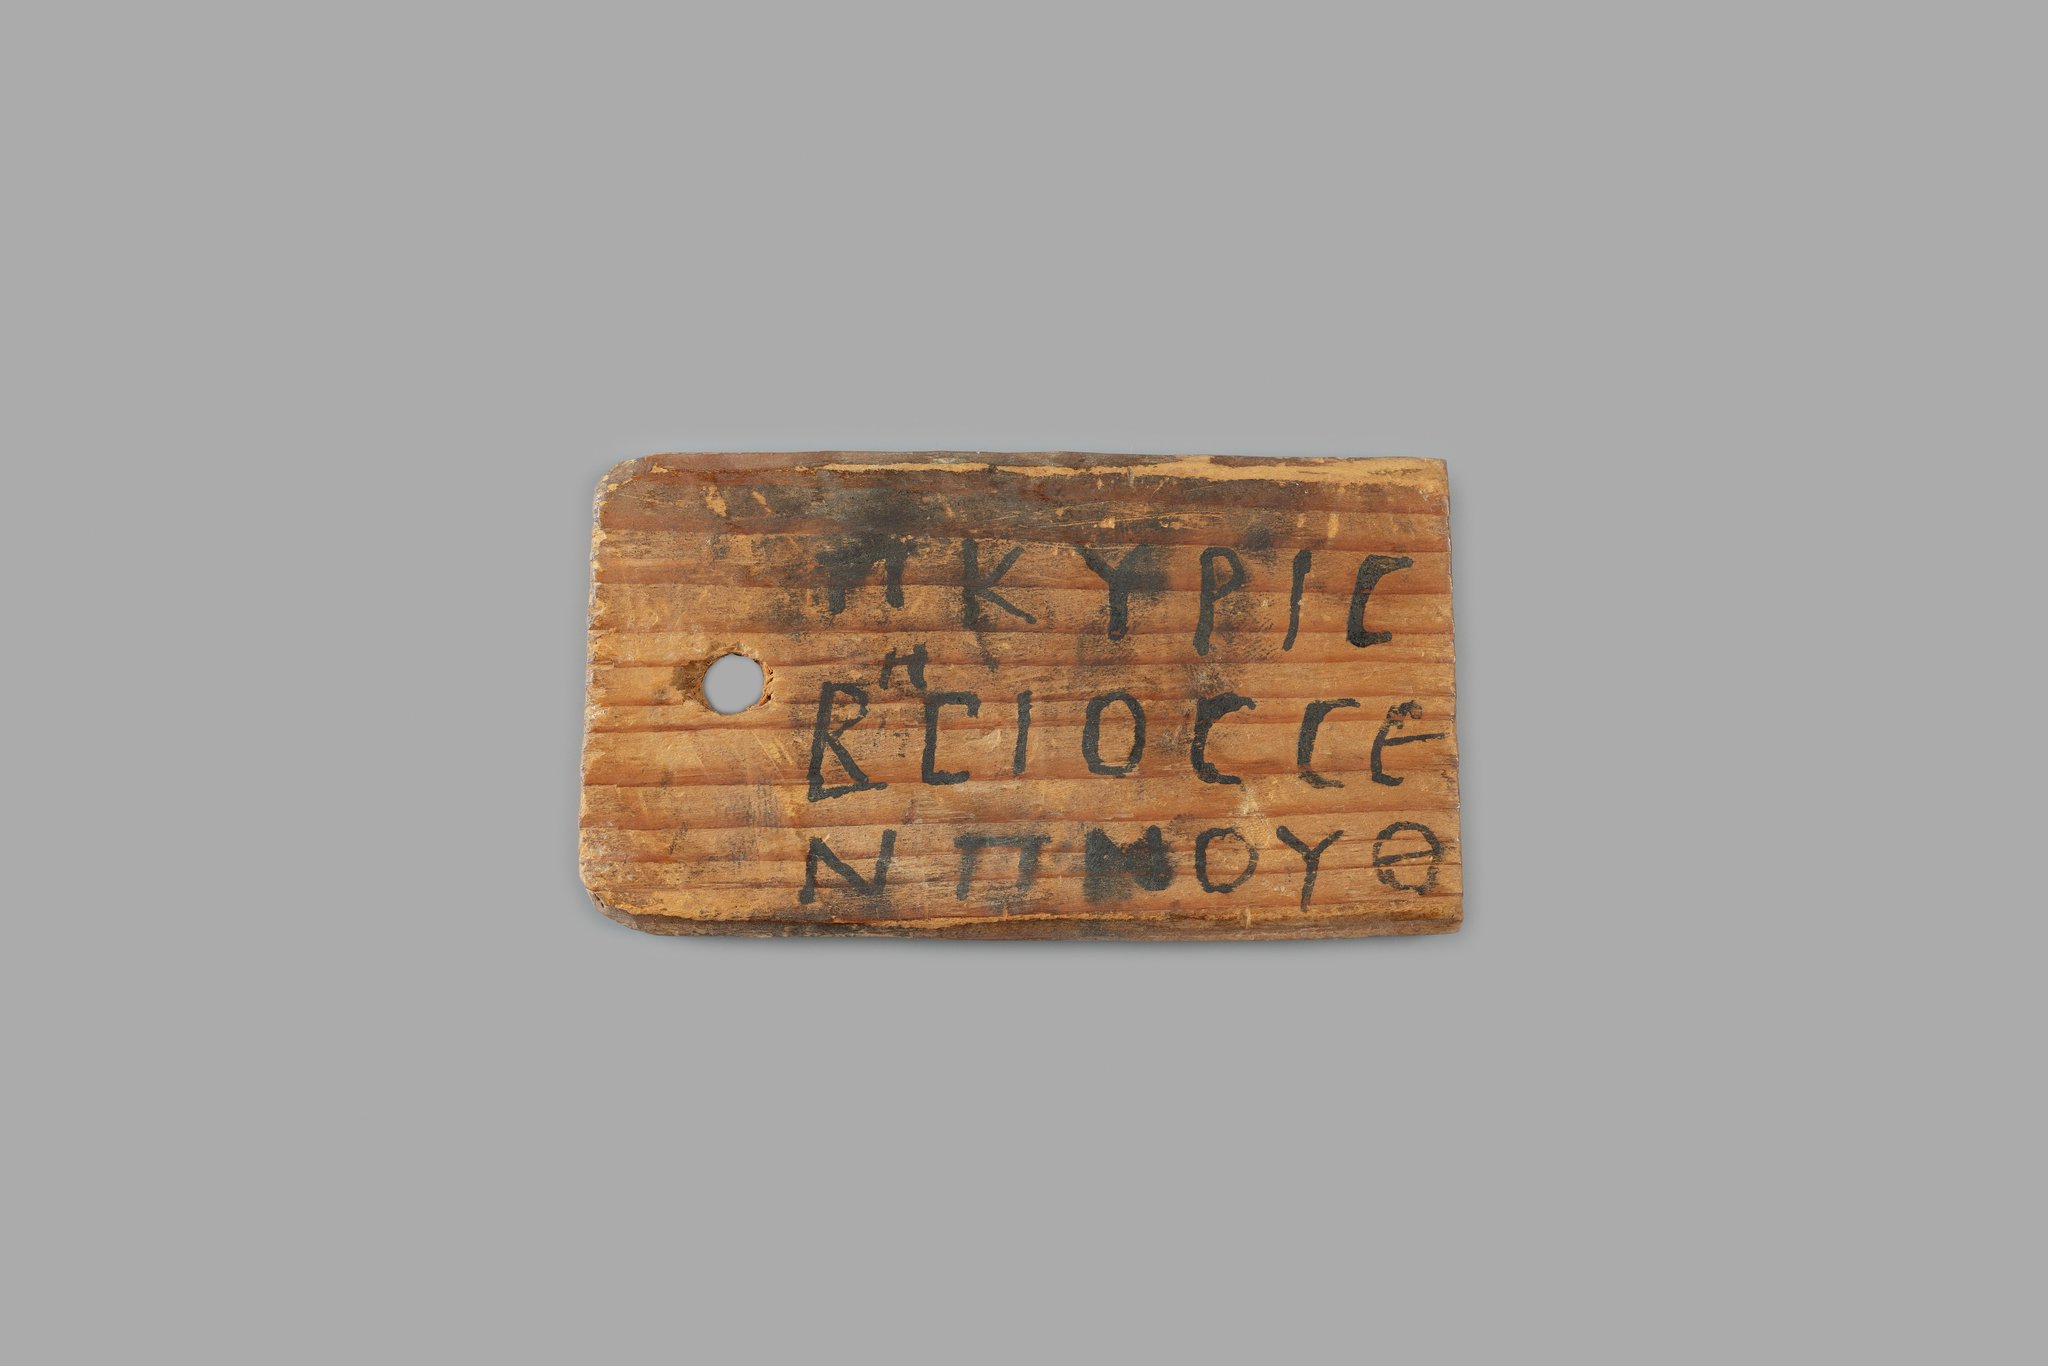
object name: mummy label, pkyris son of besis and senpnouth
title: Mummy label of Pkyris (son of) Besis and Senpnouth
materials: ink, wood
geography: northern upper egypt